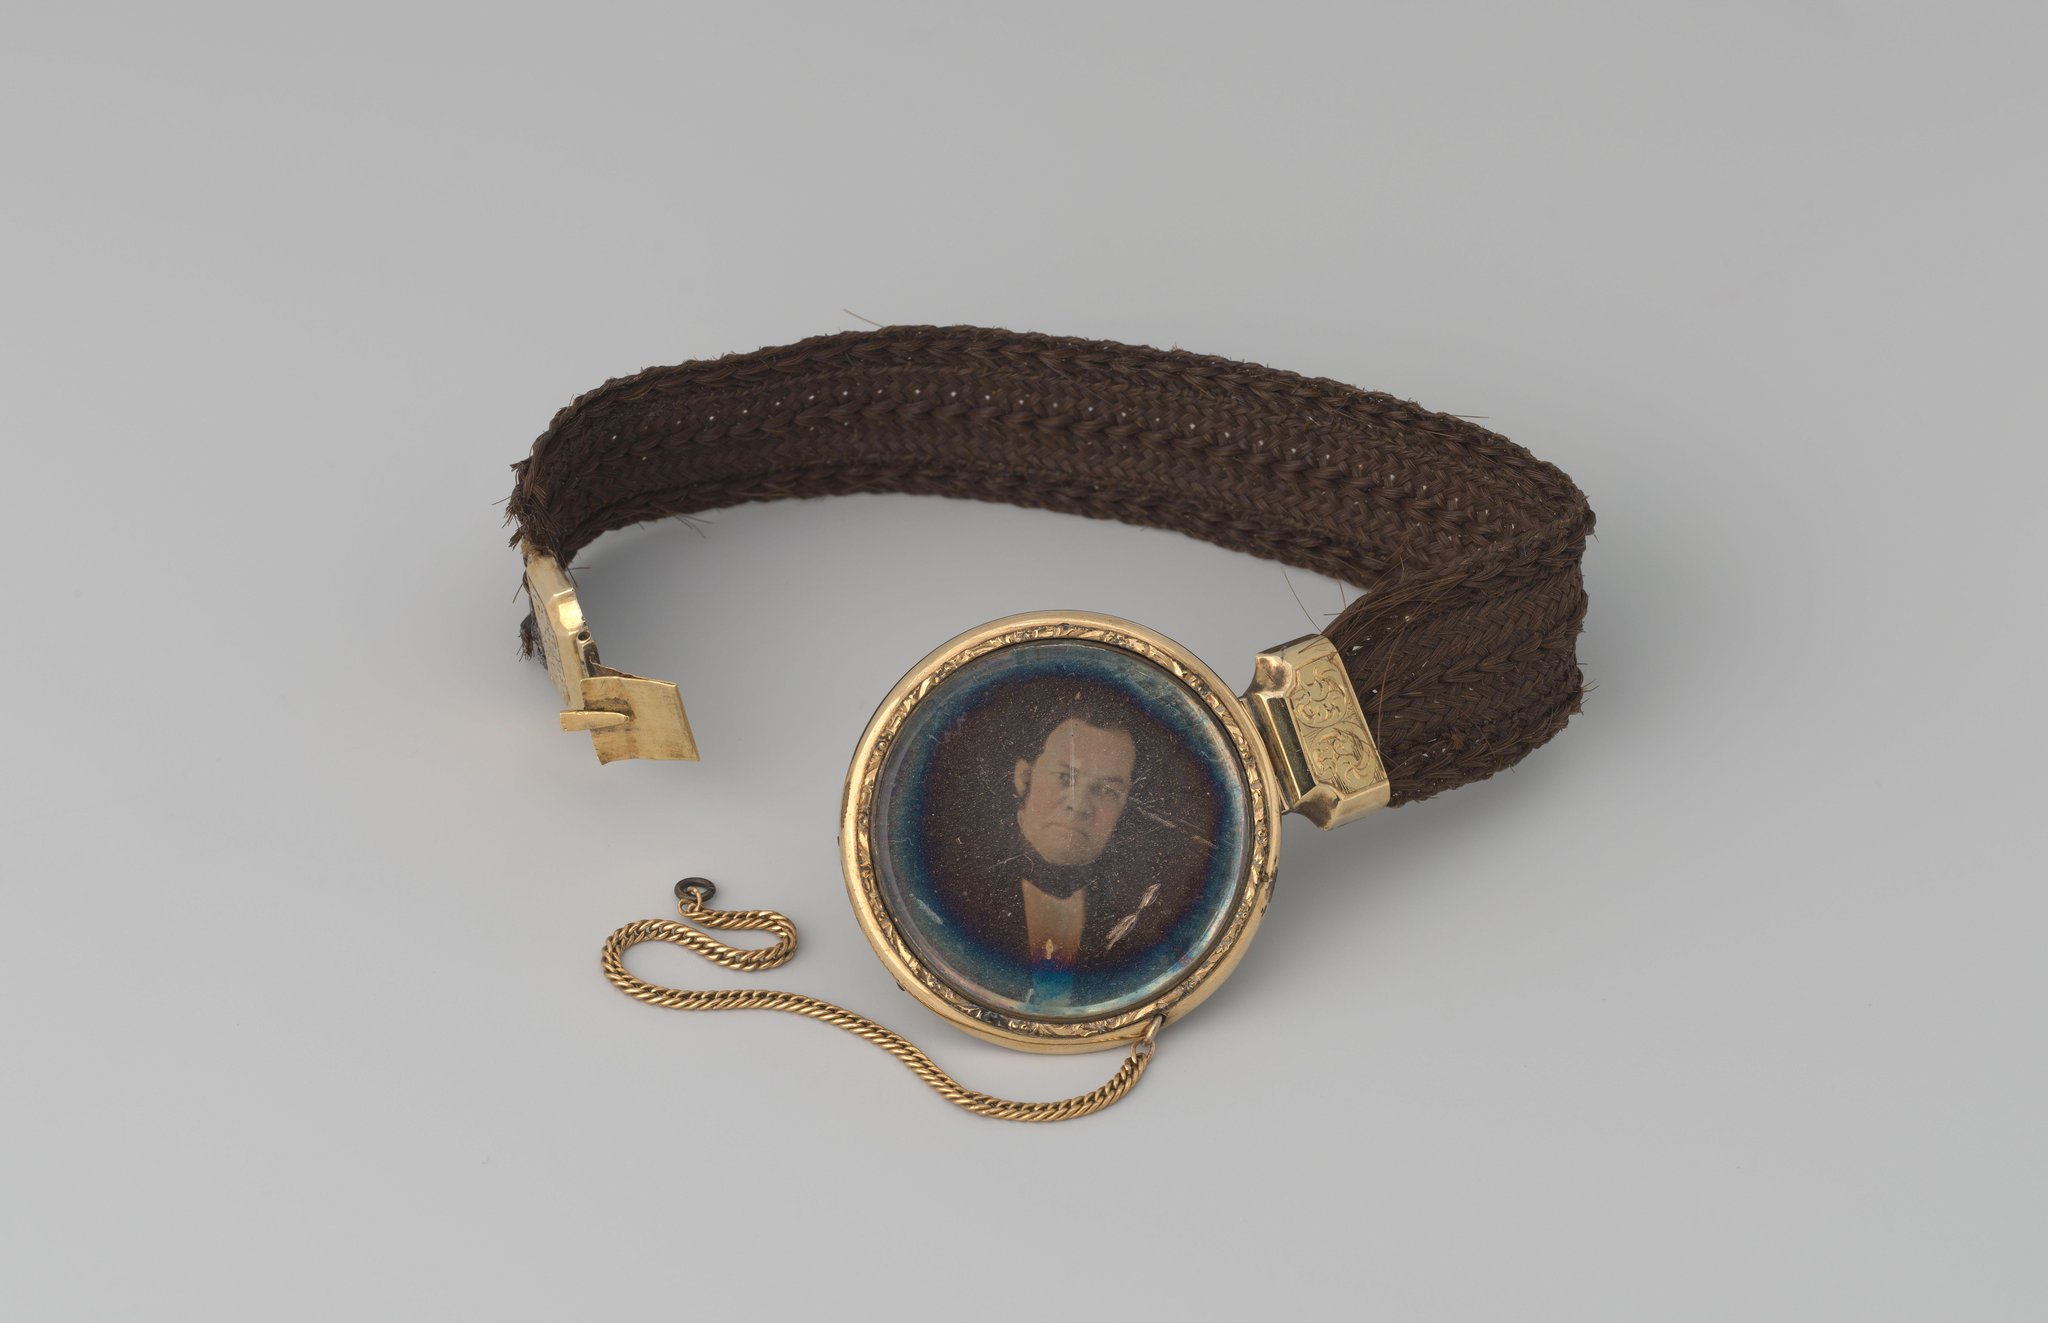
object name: bracelet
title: Armband met daguerreotypieportret van een man en twee inscripties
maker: Anonymous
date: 1850-1860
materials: copper, gold, hair, iron, leaded glass, silver, metal alloy, zinc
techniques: braiding, daguerreotype, engraving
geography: united states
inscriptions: inscription: ‘Father's Miniature / Aunt's Hair’